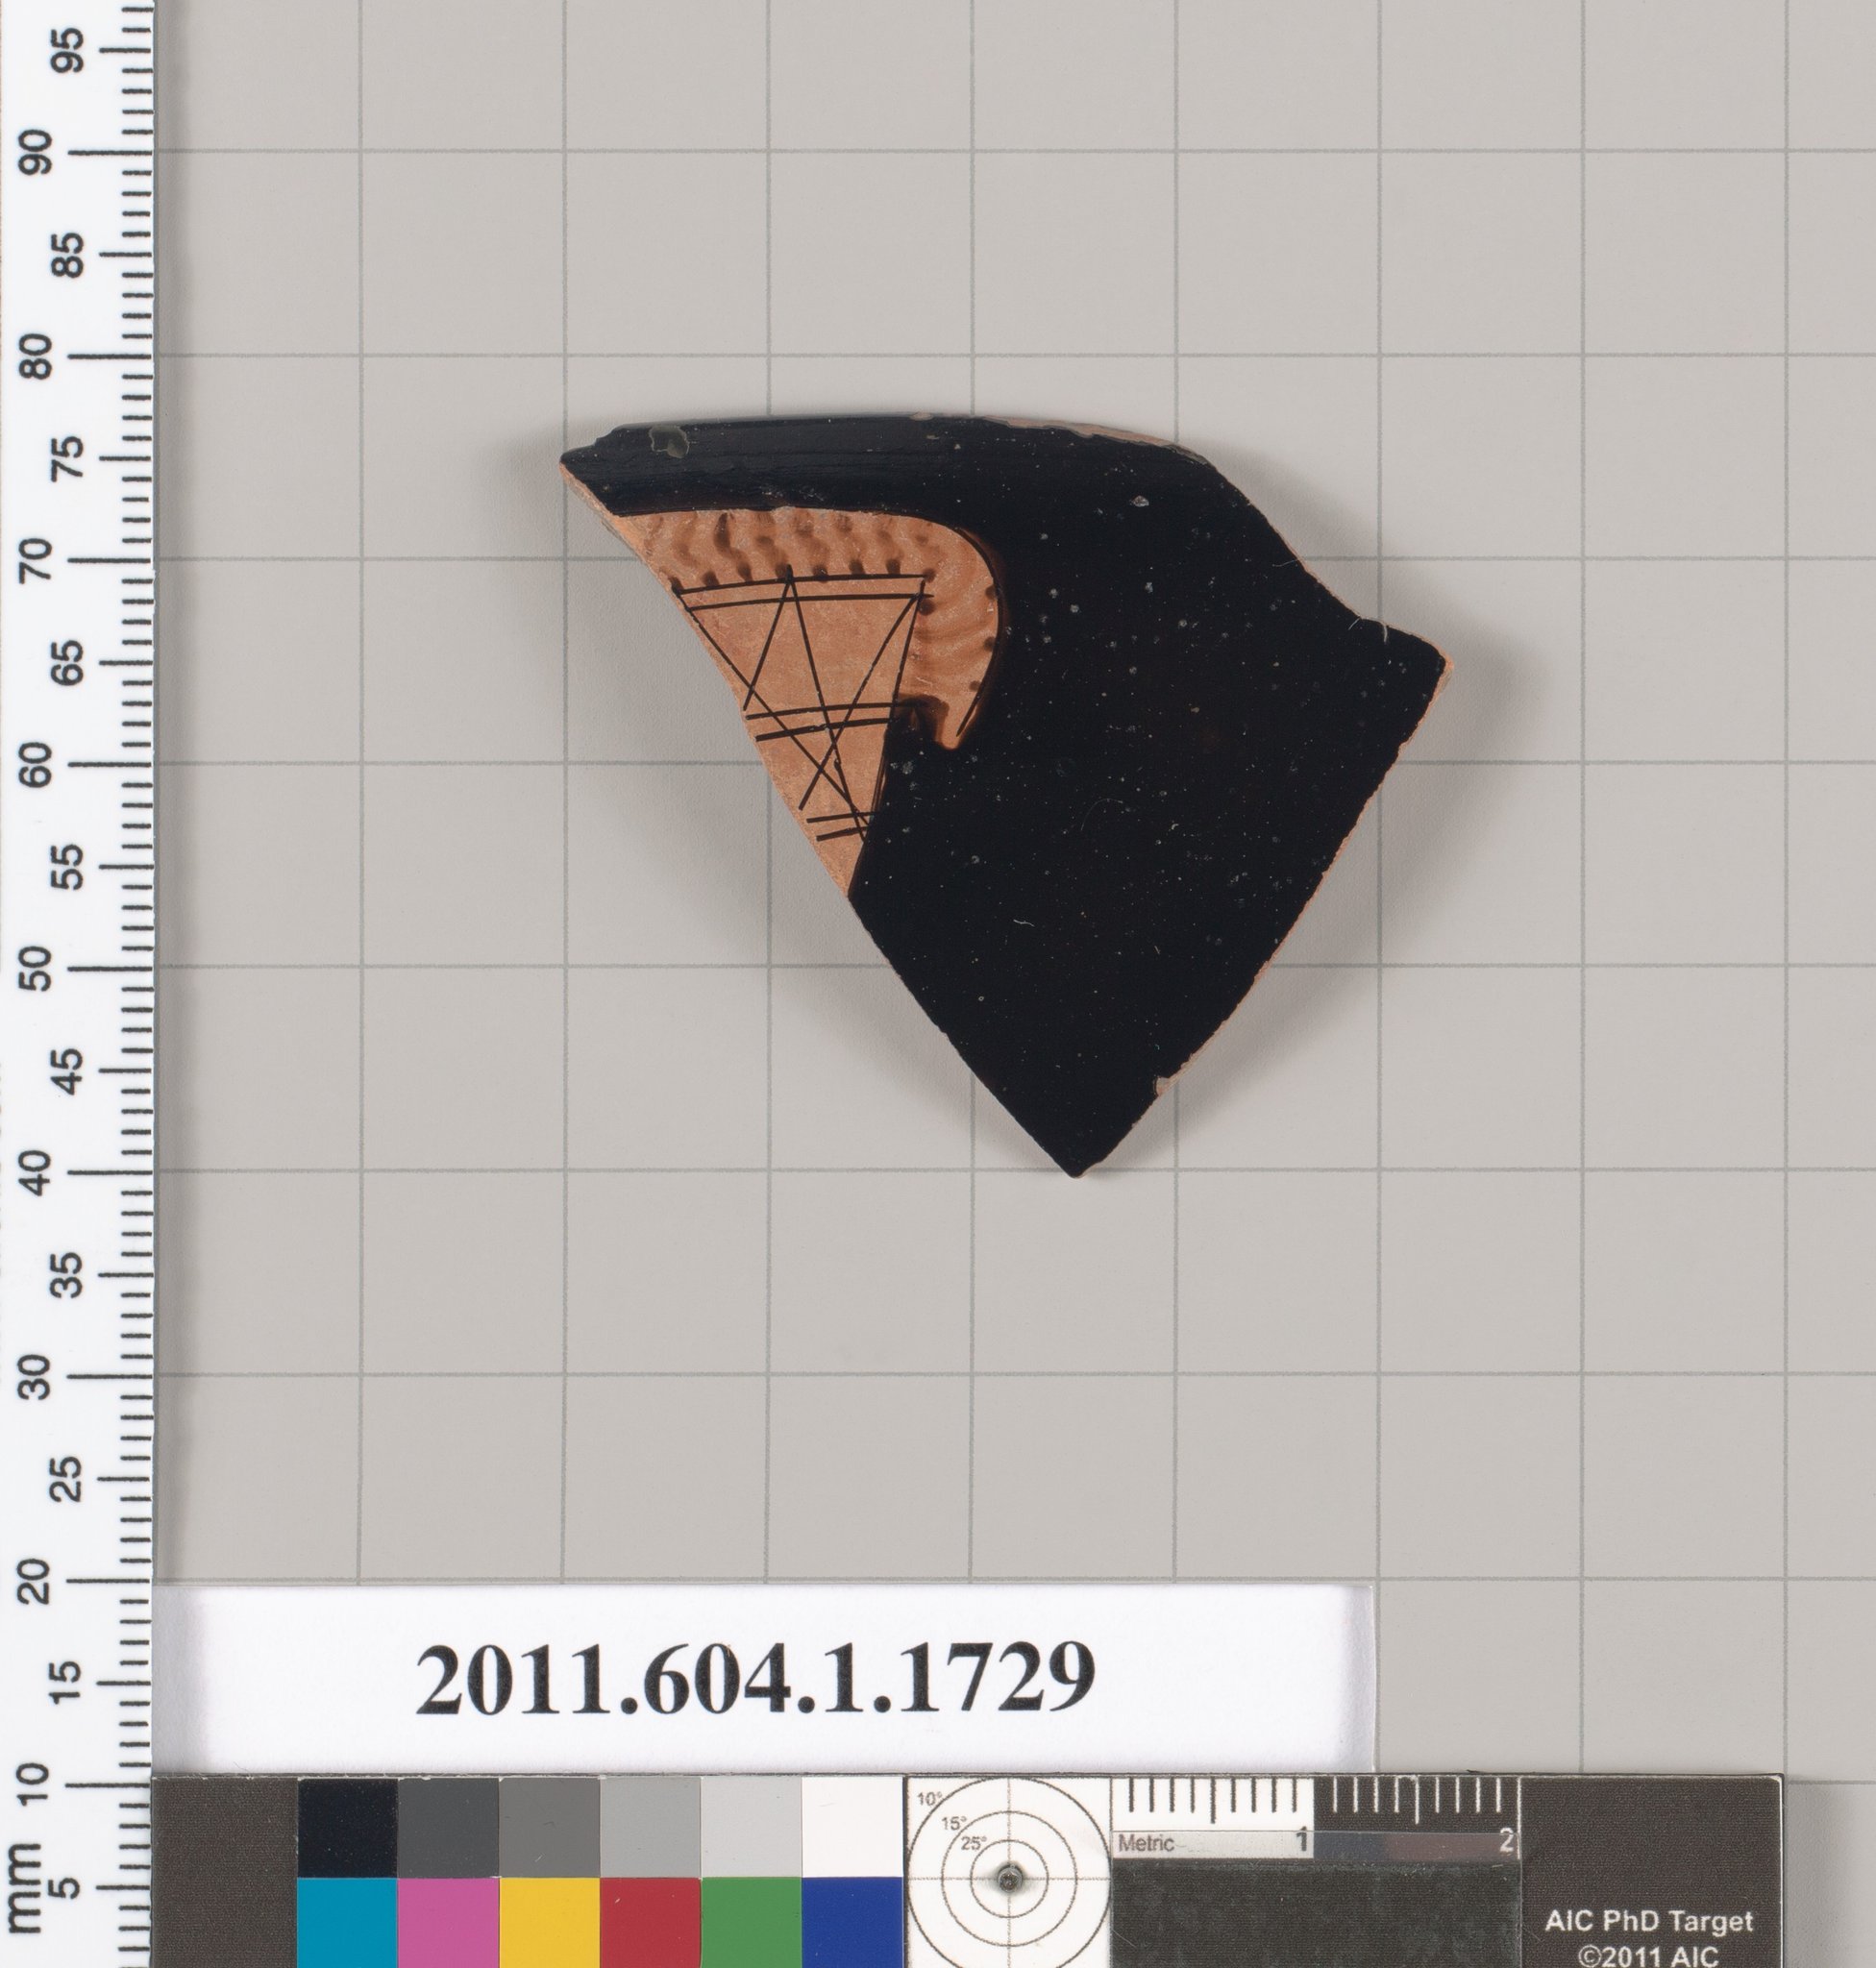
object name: kylix fragment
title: Terracotta rim fragment of a kylix (drinking cup)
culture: greek, attic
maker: telephos painter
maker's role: artist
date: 480-470 BCE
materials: terracotta